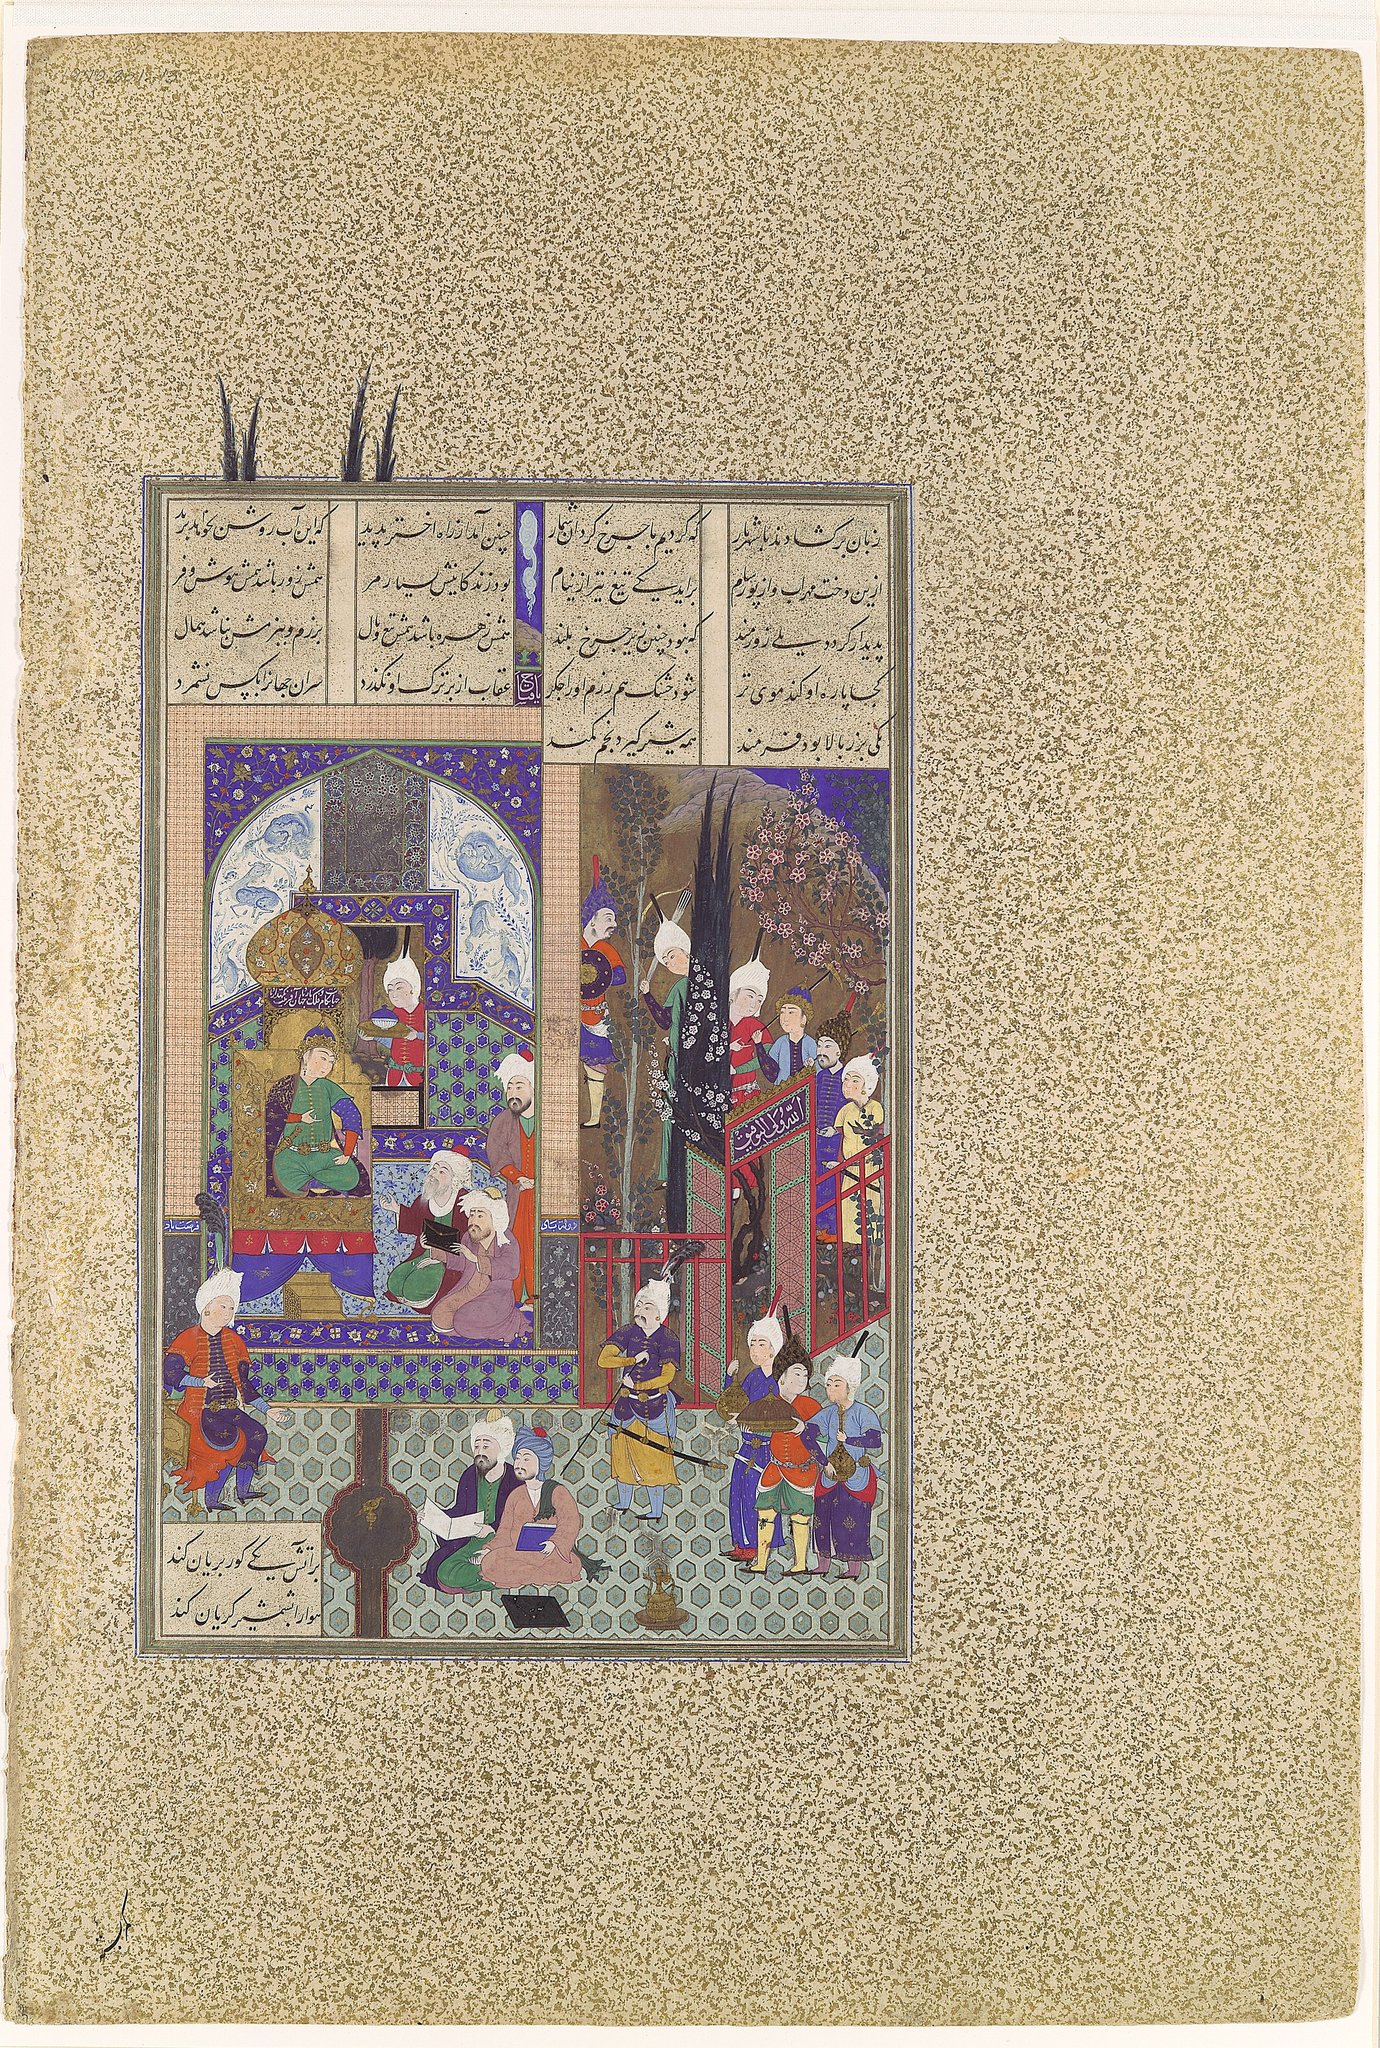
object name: folio from an illustrated manuscript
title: "The Shah's Wise Men Approve of Zal's Marriage", Folio 86v from the Shahnama (Book of Kings) of Shah Tahmasp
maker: abu'l qasim firdausi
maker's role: author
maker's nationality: iranian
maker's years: 935-1020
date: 1525-1530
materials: gold, ink, paper, silver, watercolor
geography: iran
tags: men